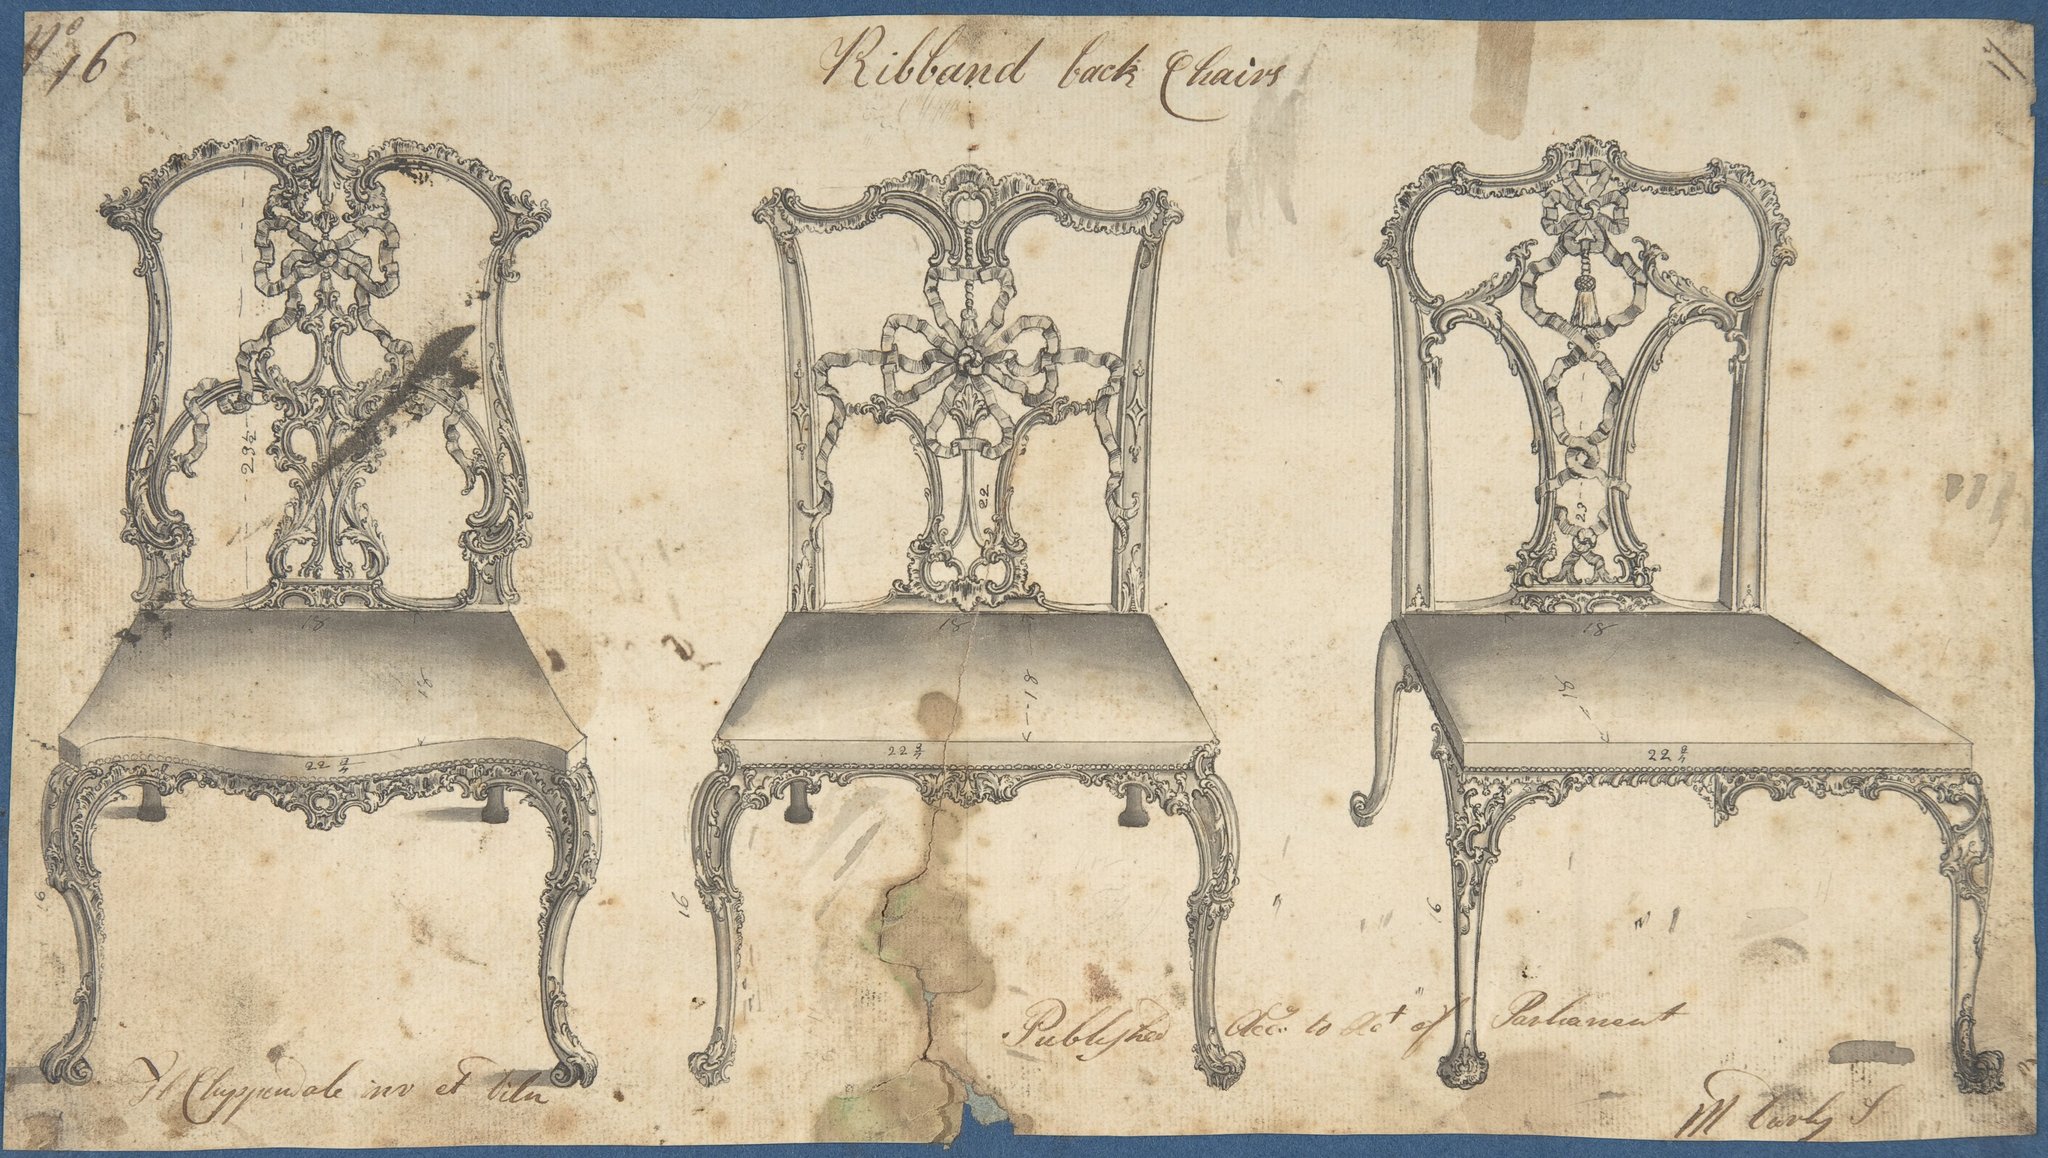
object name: drawing ornament architecture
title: Ribband Back Chairs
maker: thomas chippendale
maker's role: artist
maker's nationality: british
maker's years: 1718-1779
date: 1754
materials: ink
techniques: brush, pen, wash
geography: london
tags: chairs